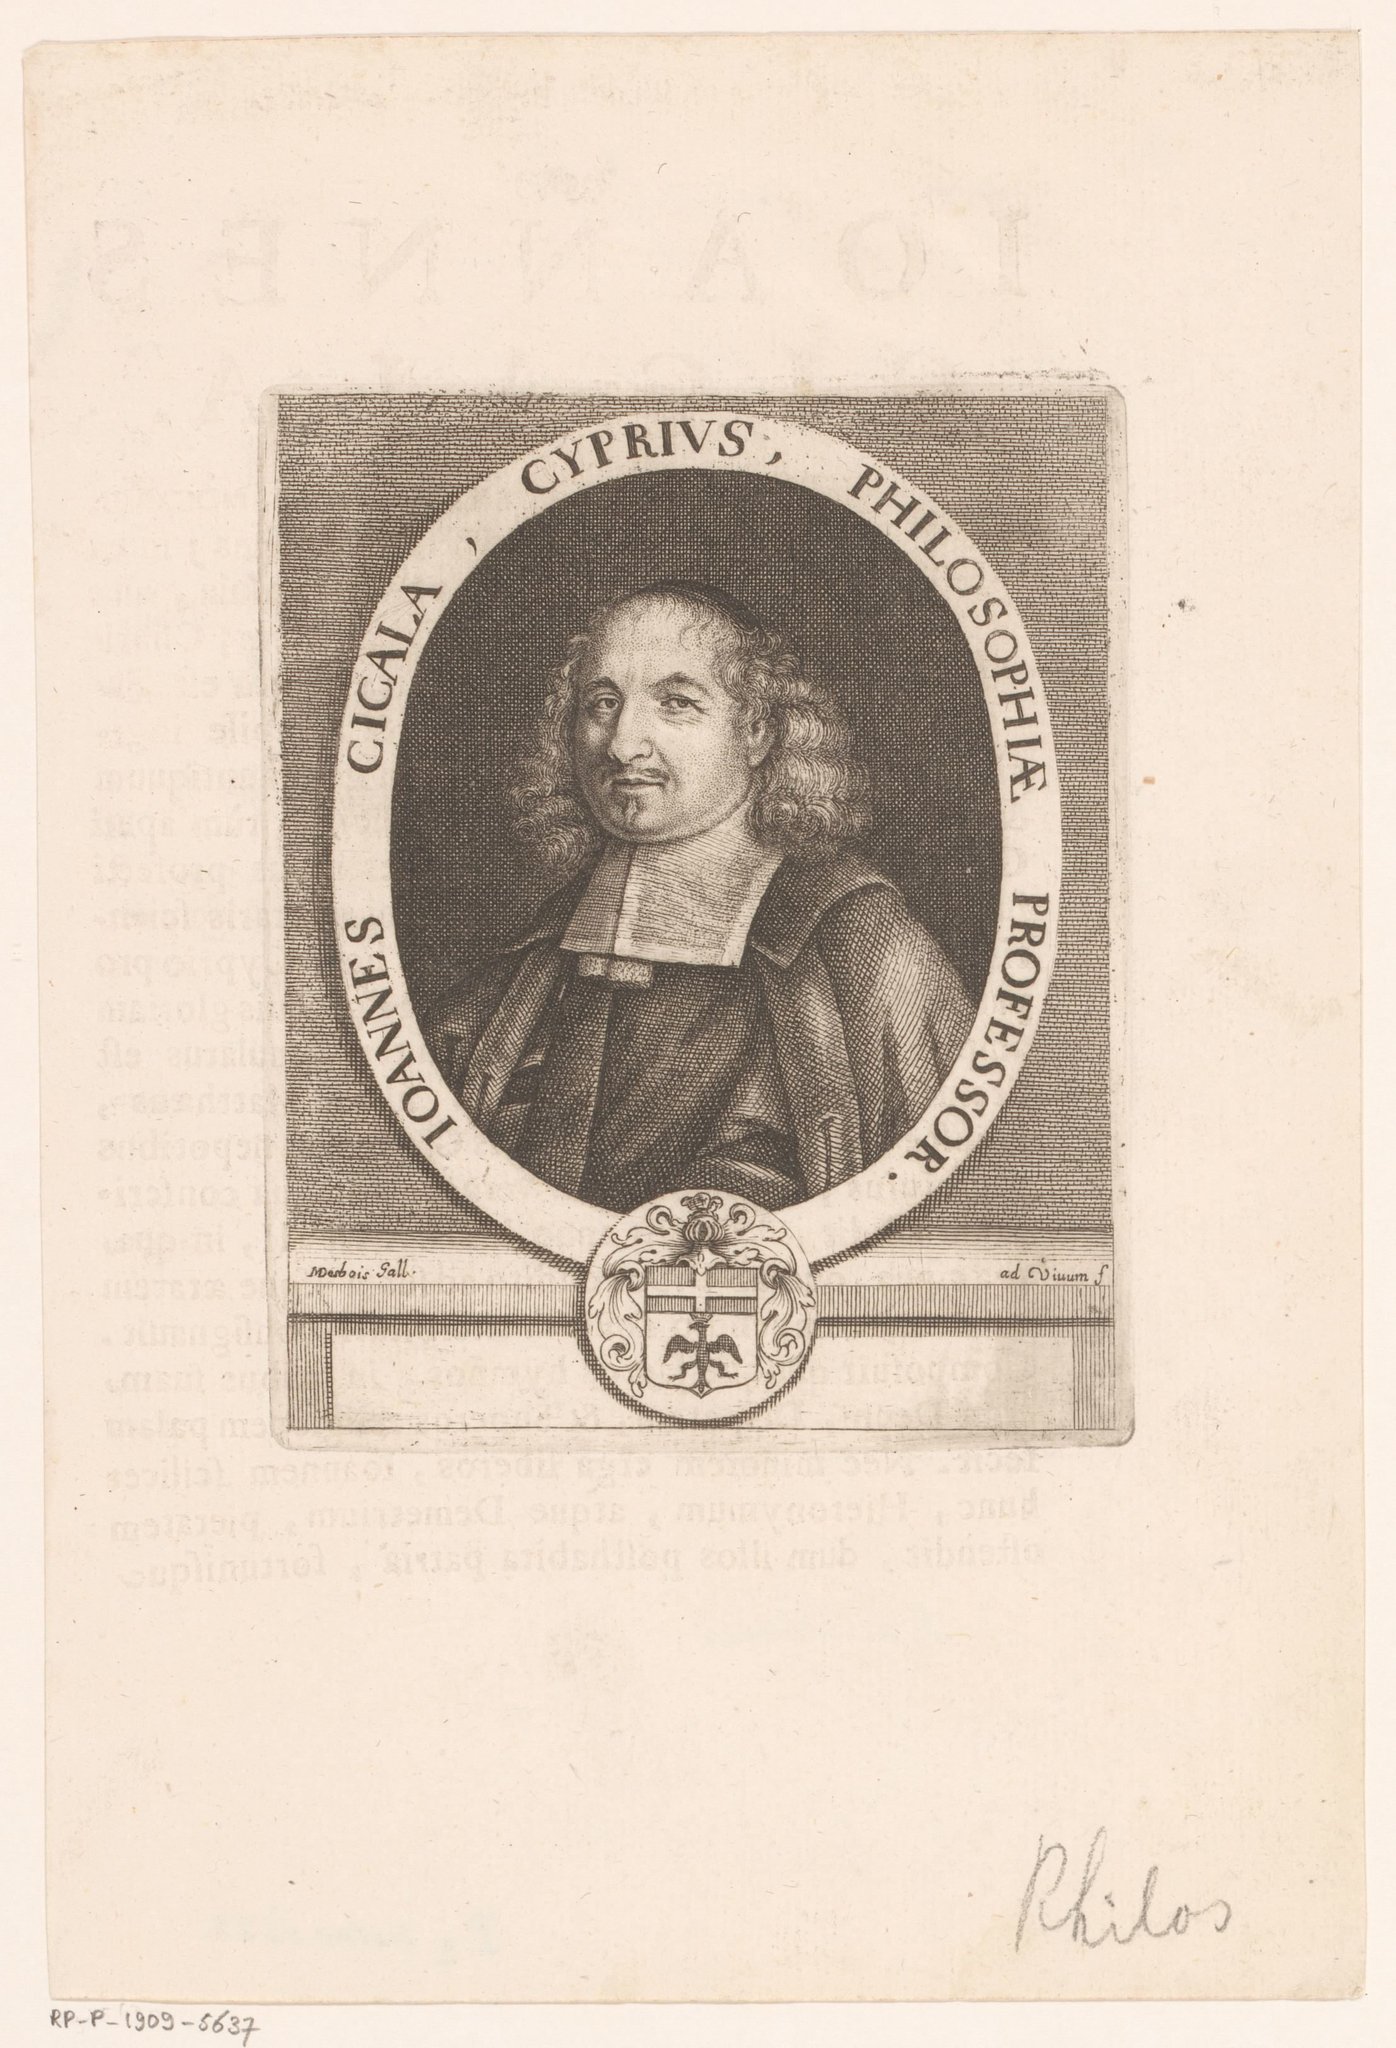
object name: print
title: Portret van Ioannis Kigalas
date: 1682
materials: paper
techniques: engraving, etching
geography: padua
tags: historical persons, professor, armorial bearing, heraldry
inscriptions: collector's mark: Lugt 2228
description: Prent uit: Patin, Charles. Lyceum Patavinum: sive icones et vitae professorum. Padua: Frambotti, Petri Mariae, 1682.